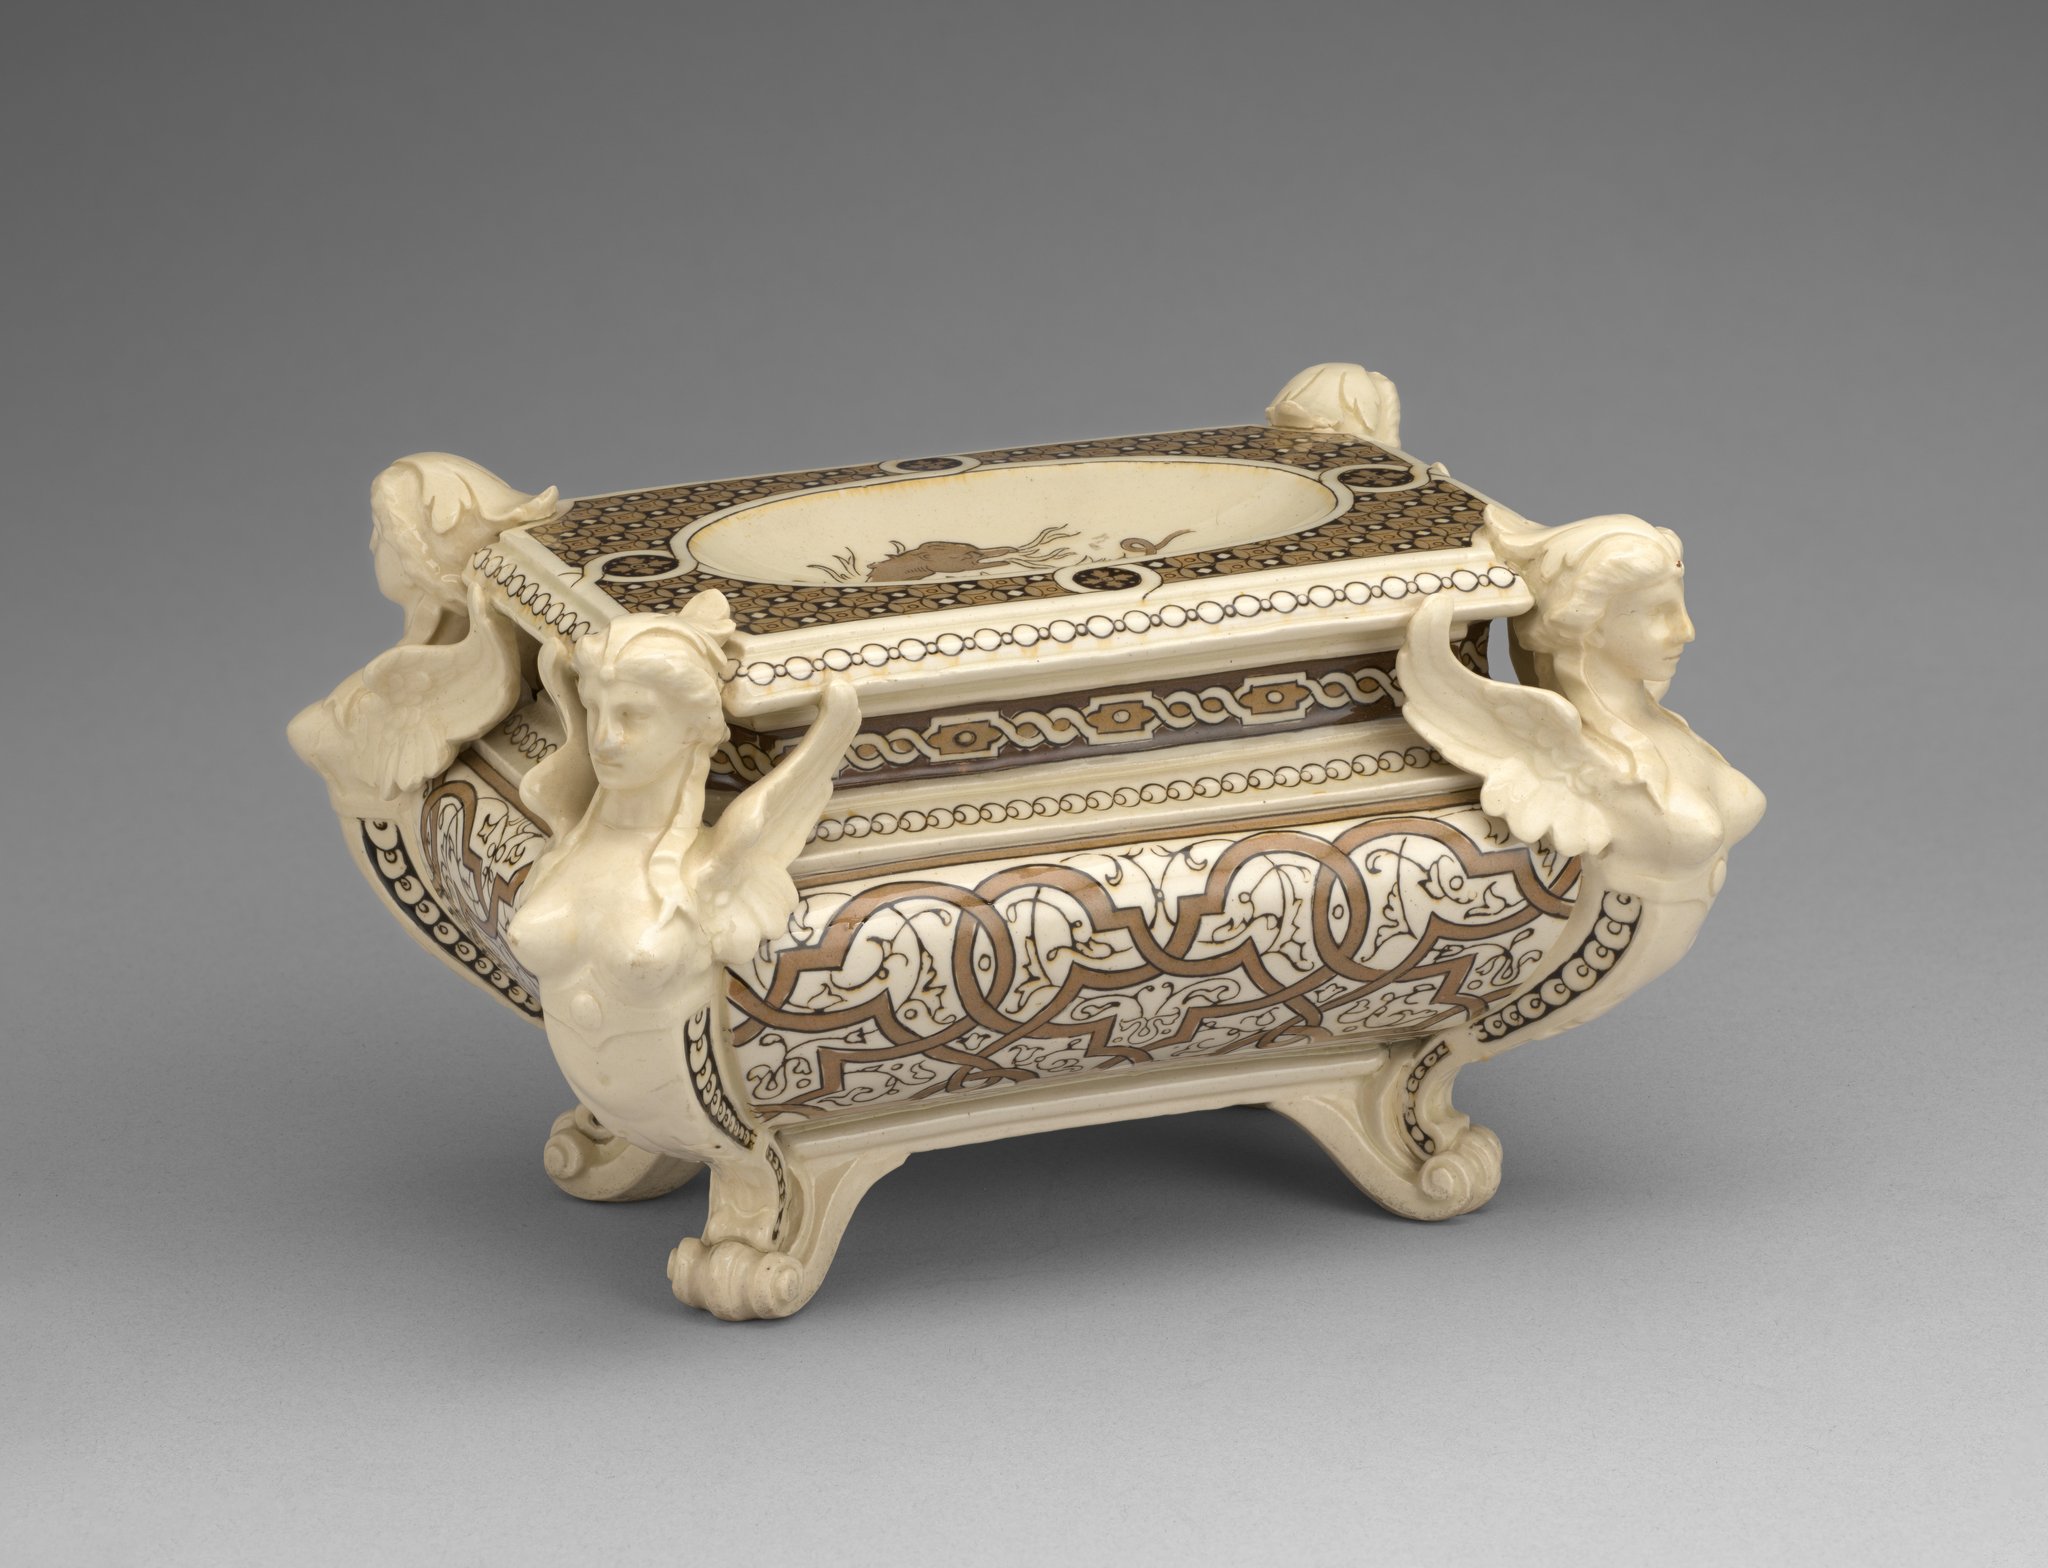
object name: salt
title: Henri II Ware salt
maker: joseph francois léon arnoux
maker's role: designer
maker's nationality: french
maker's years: 1816-1902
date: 1870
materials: earthenware, enamel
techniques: glazing, inlay